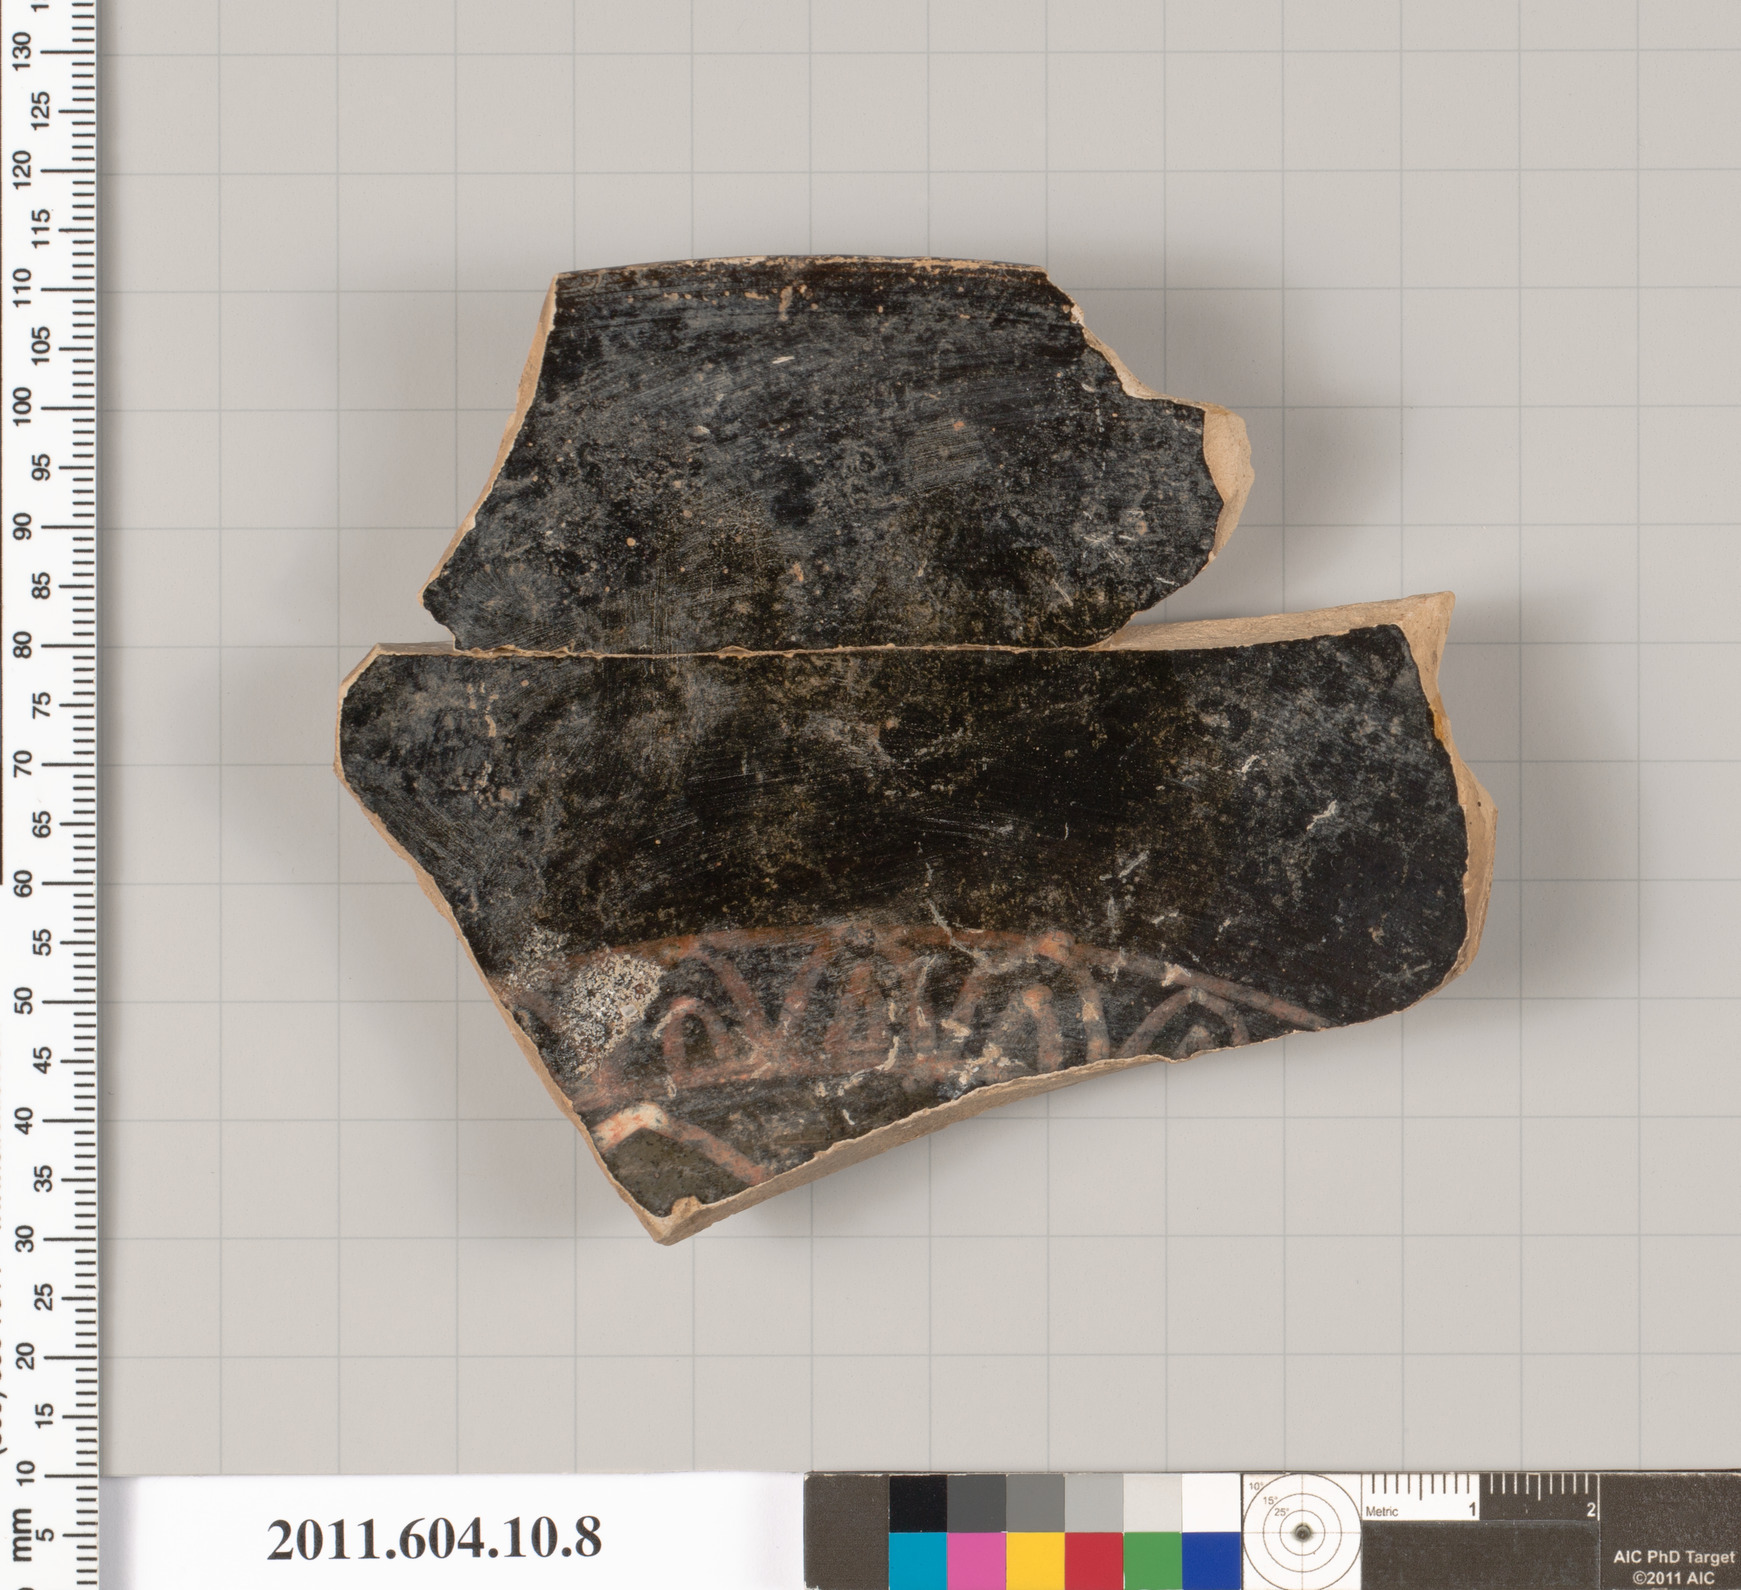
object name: kylix fragment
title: Terracotta rim fragment of a kylix (drinking cup)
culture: etruscan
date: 434-368 BCE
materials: terracotta